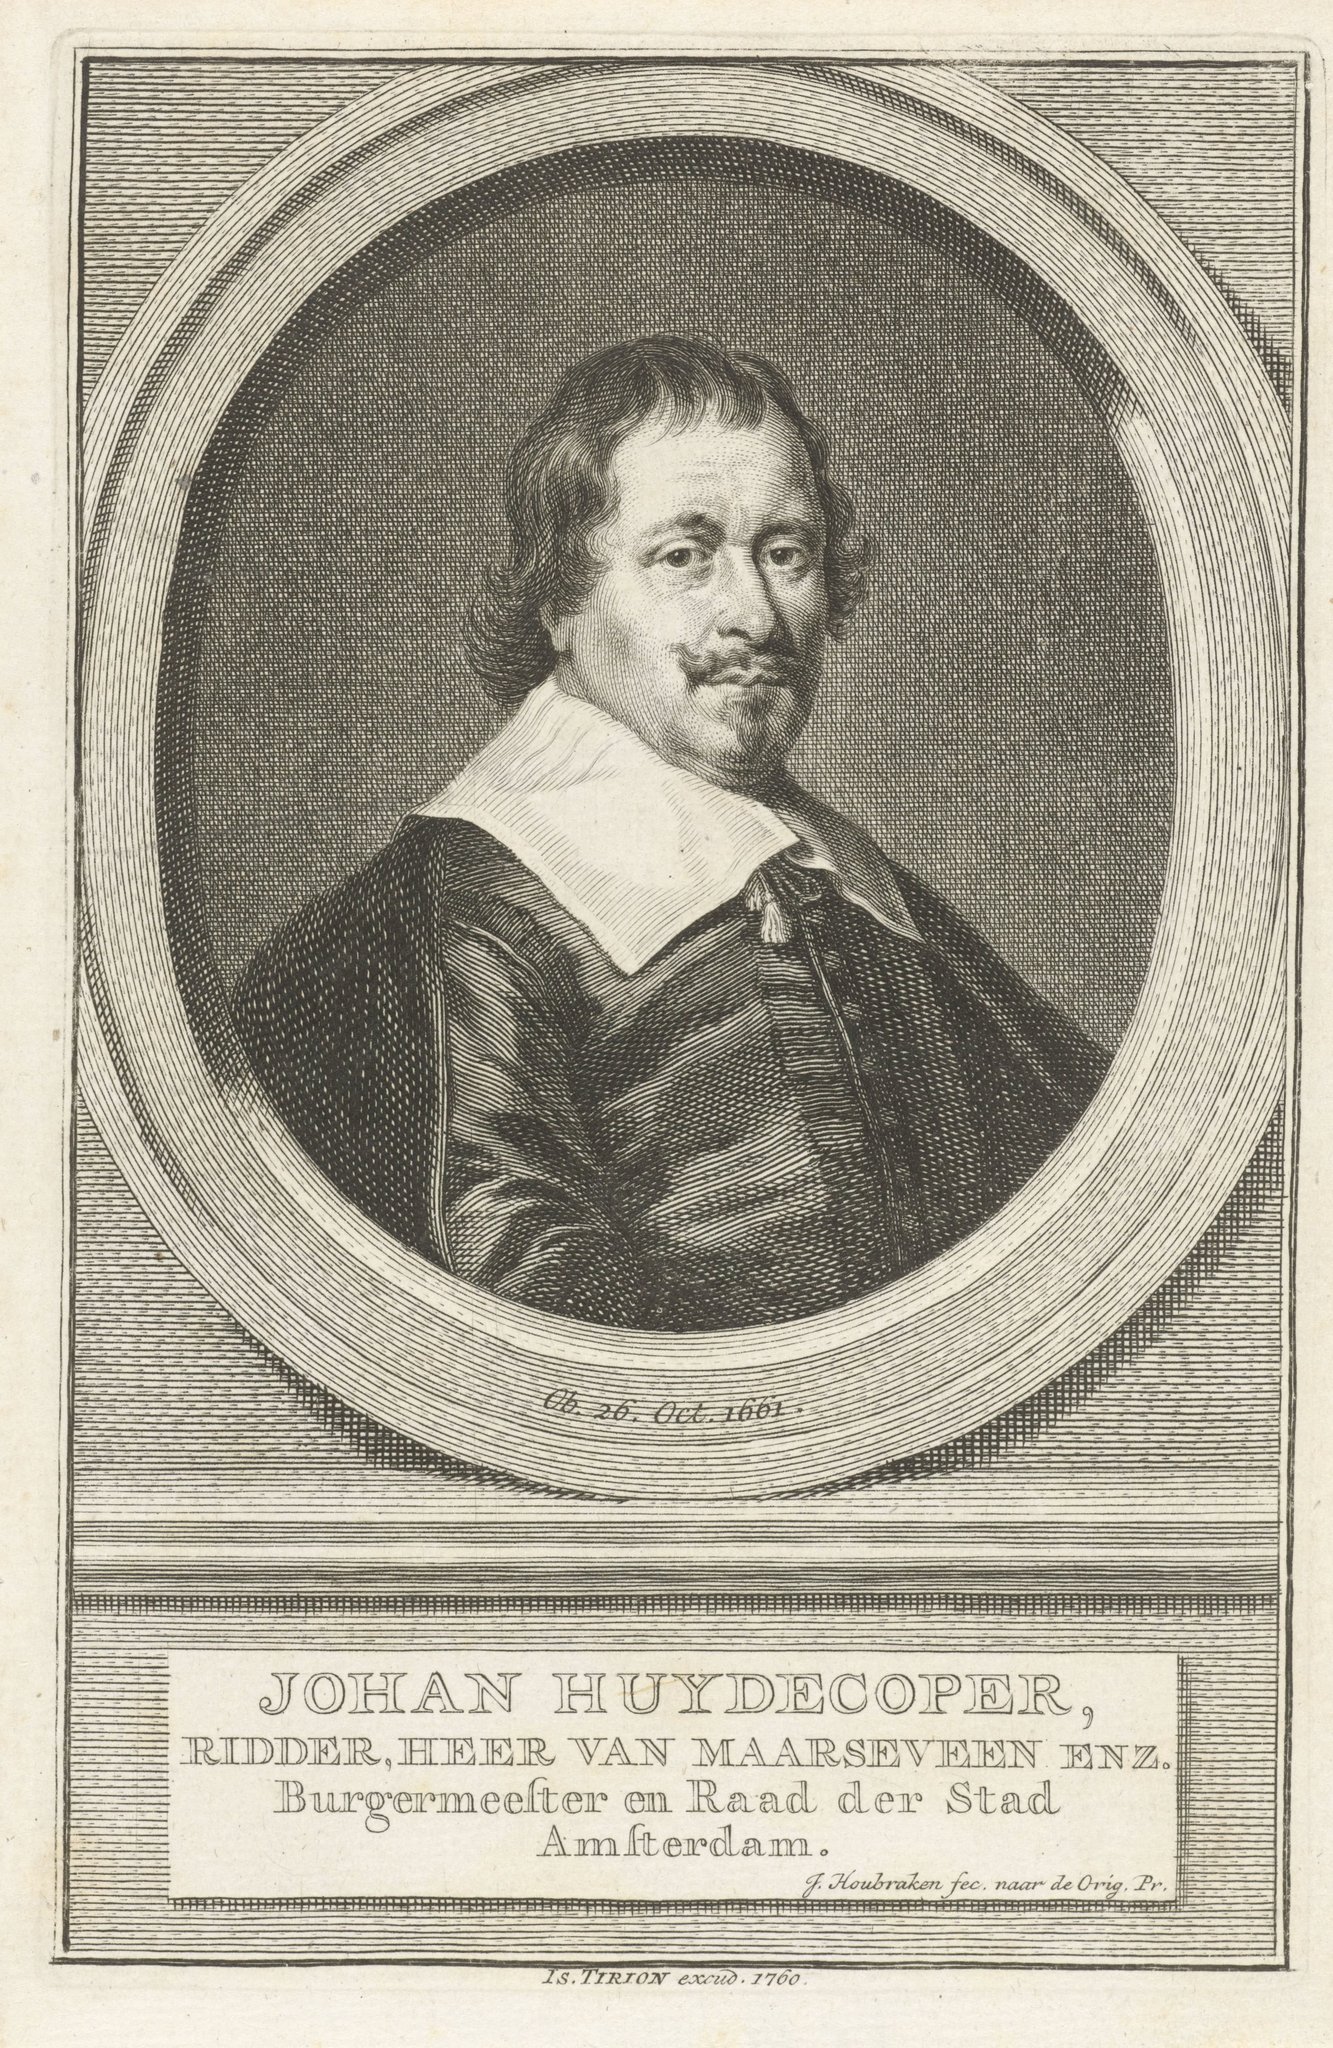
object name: print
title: Portret van Joan Huydecoper I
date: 1760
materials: paper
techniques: engraving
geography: amsterdam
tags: amsterdam, mayor, joan huydecoper van maarseveen (i)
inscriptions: collector's mark: Lugt 2228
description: Buste naar rechts van Joan Huydecoper I van Maarseveen, in een ovaal. Het portret rust op een plint waarop zijn naam en gegevens in vier regels in het Nederlands.